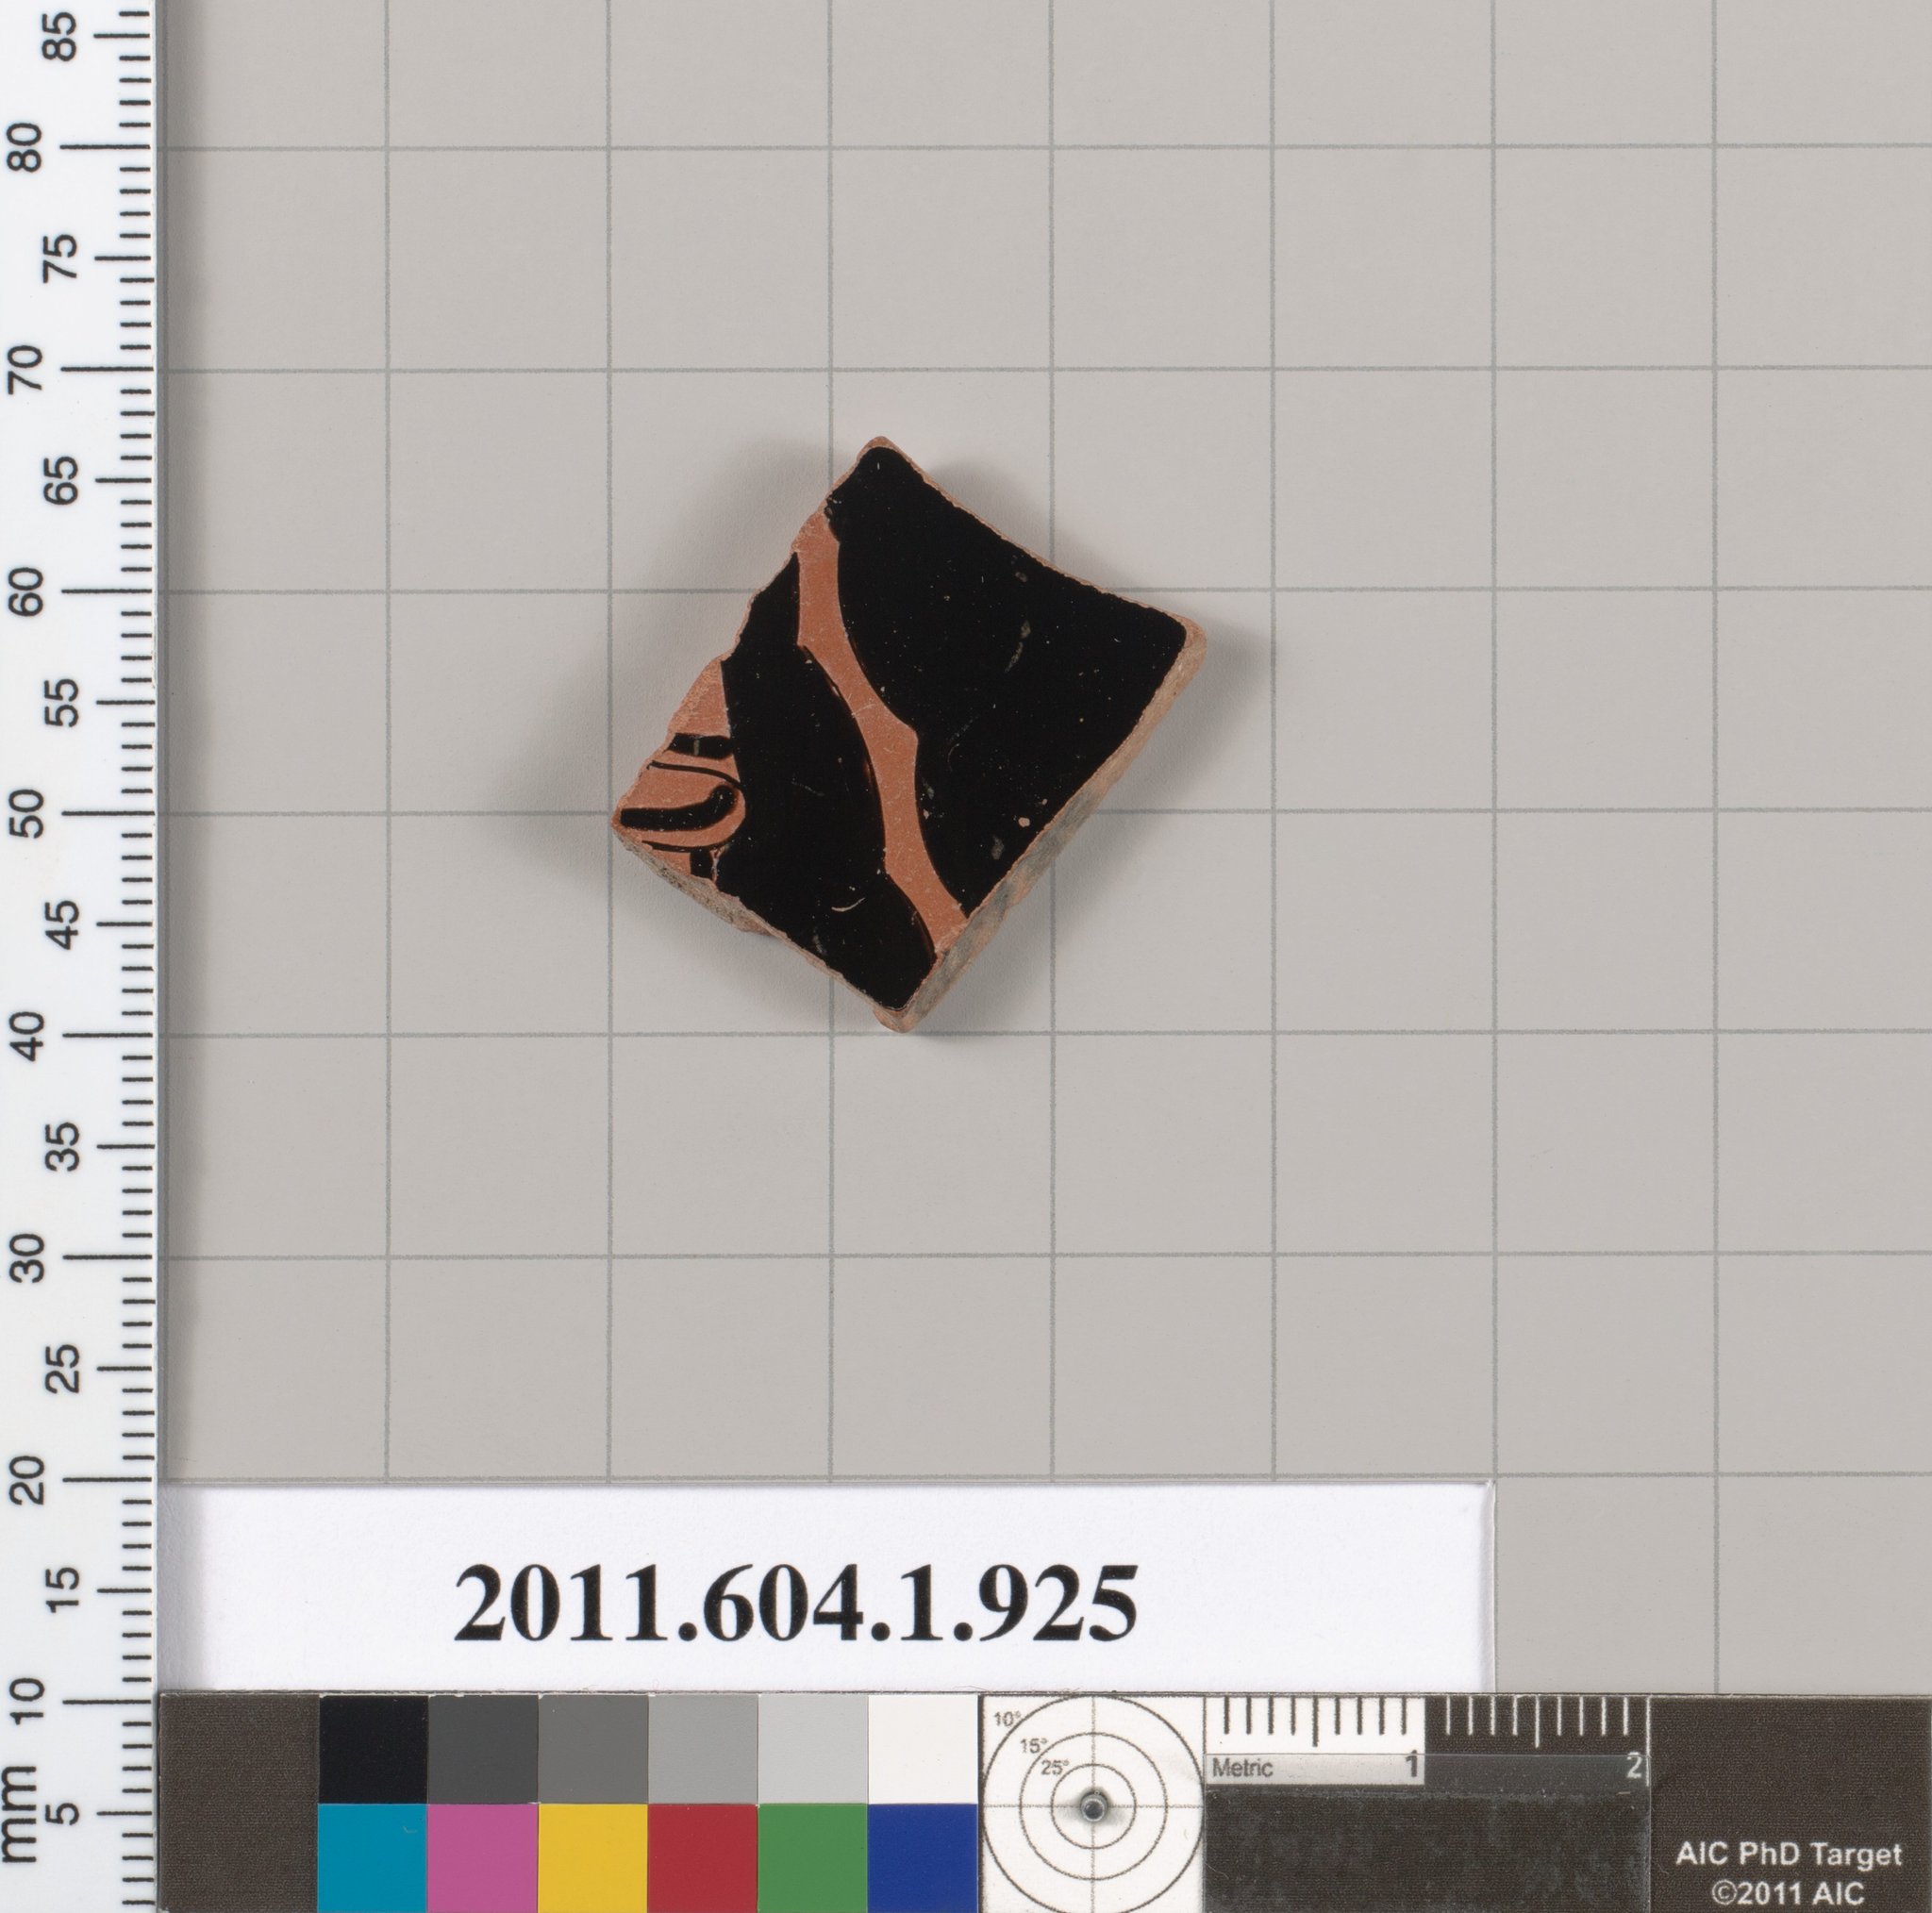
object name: kylix fragment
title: Terracotta fragment of a kylix (drinking cup)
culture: greek, attic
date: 490-480 BCE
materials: terracotta